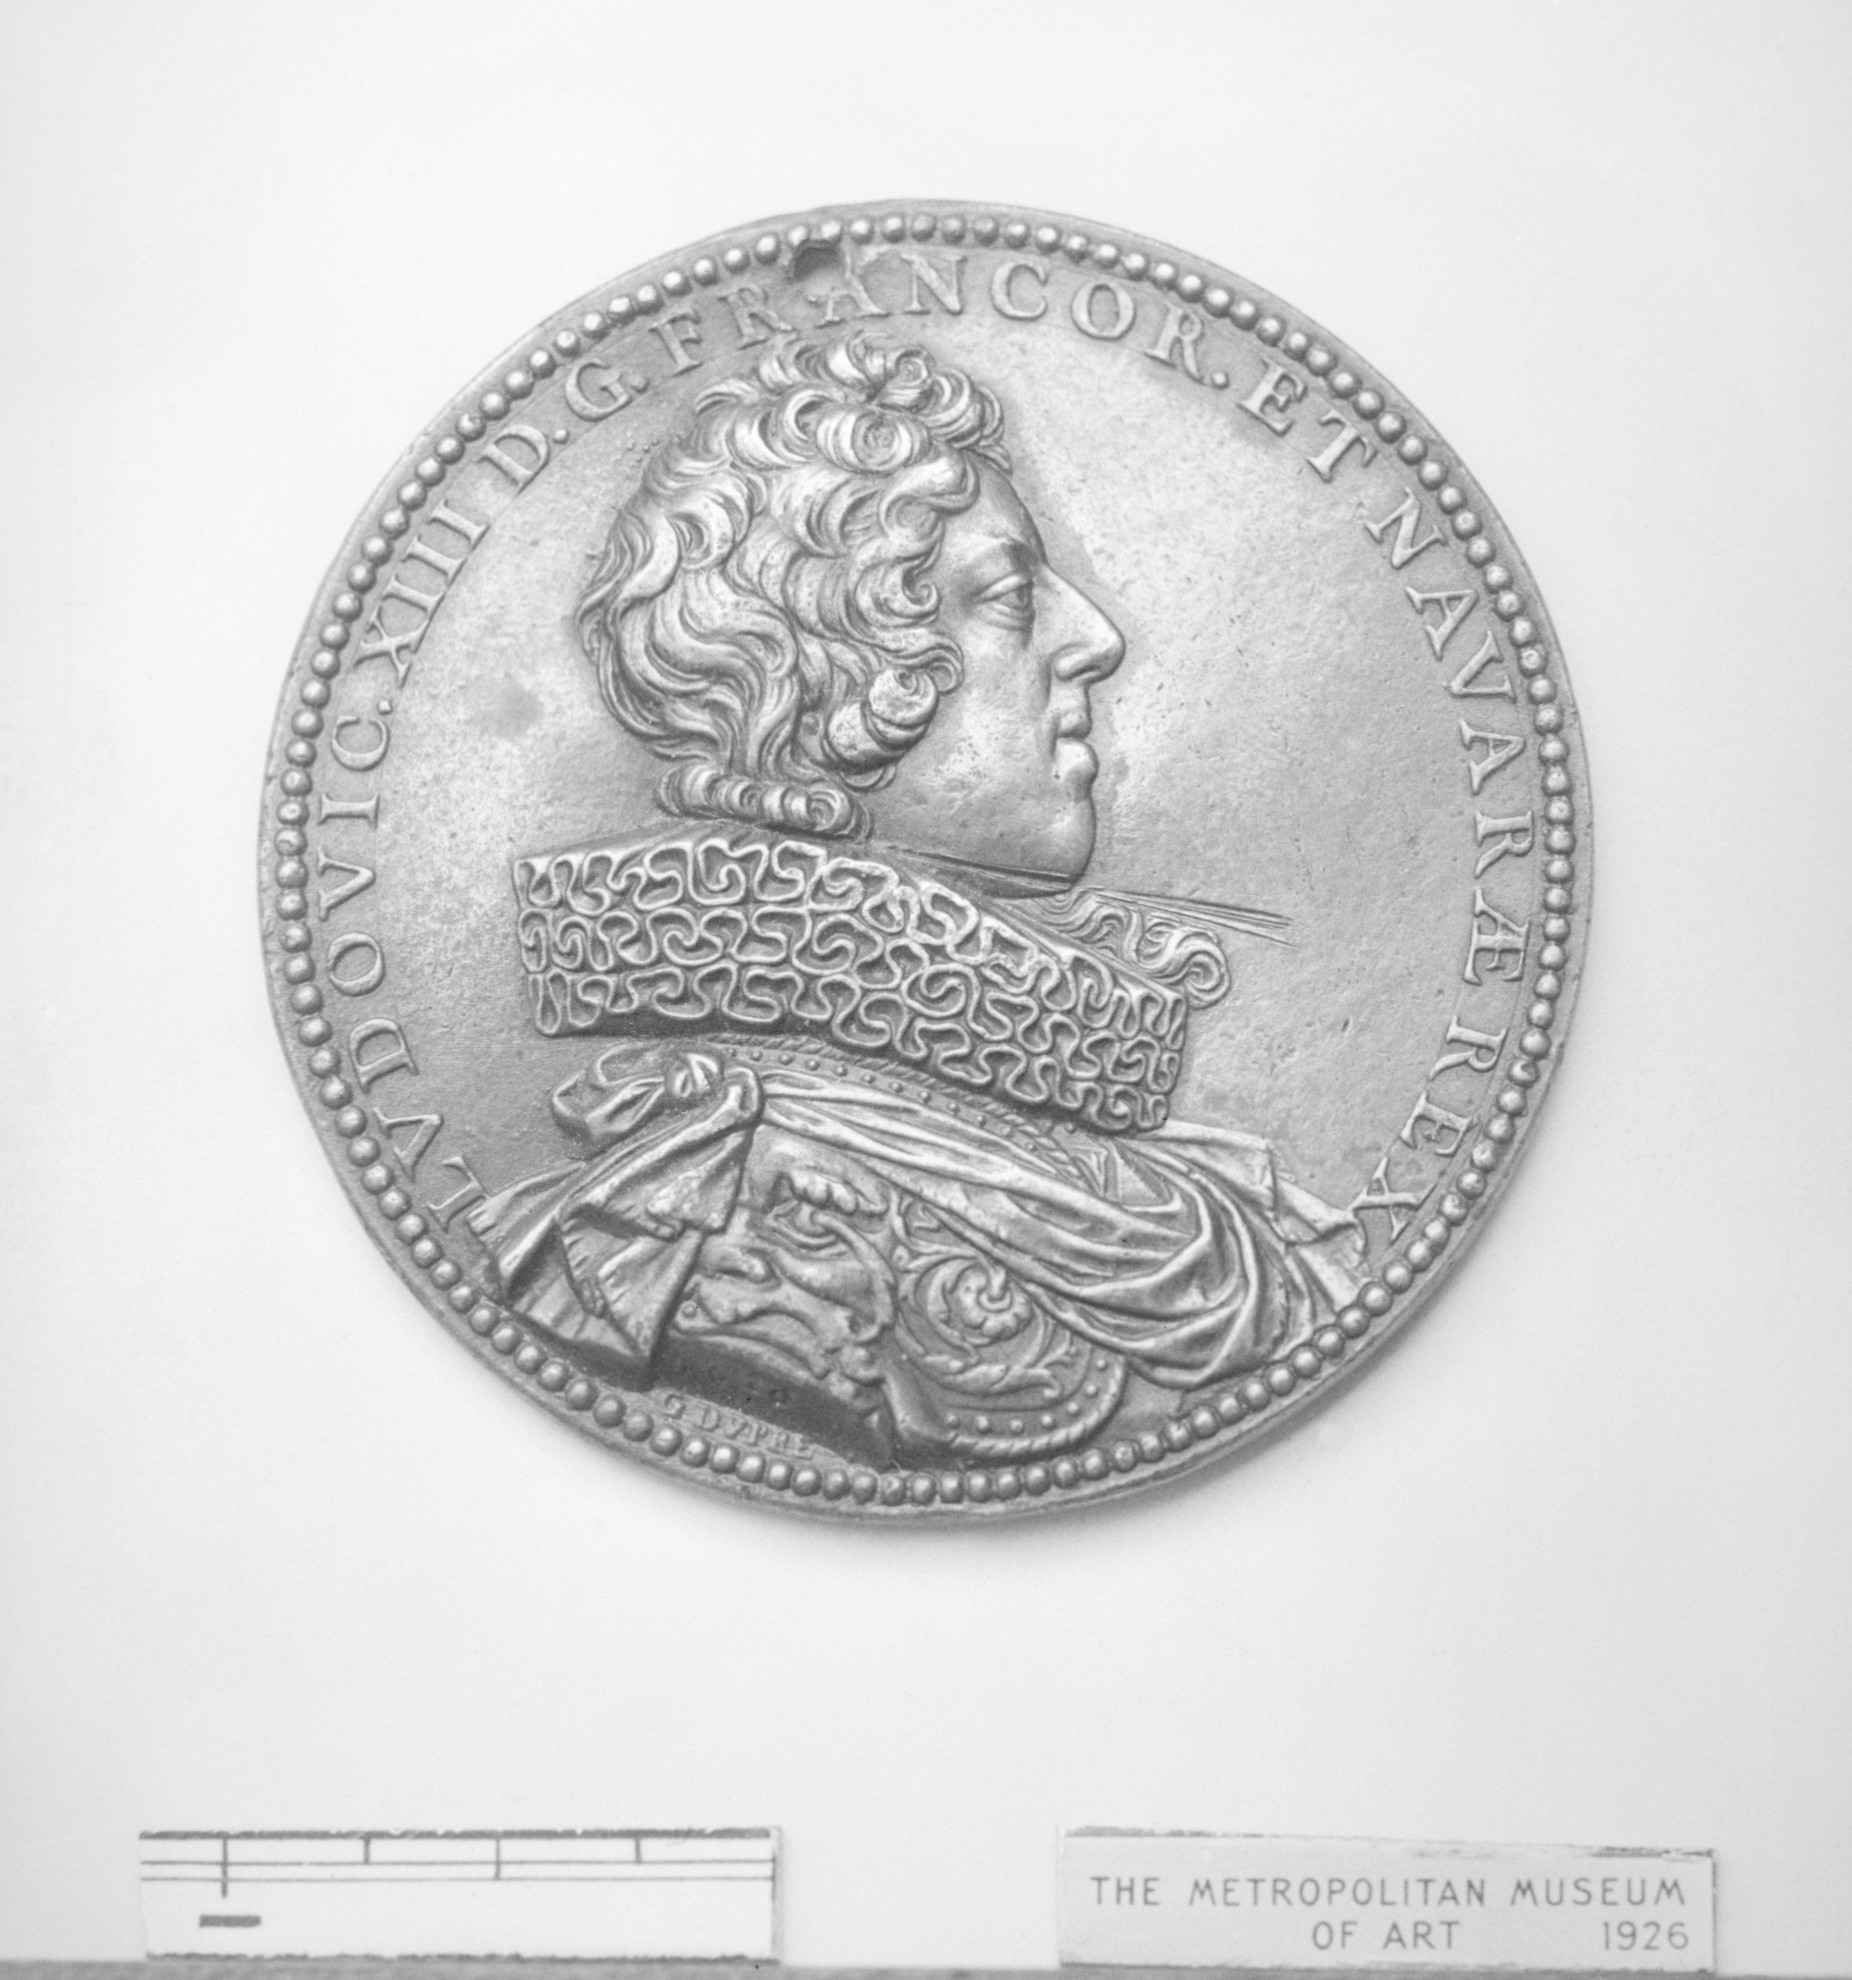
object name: medal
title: Louis XIII, King of France (b. 1601, r. 1610–43)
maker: guillaume dupré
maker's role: artist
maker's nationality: french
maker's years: 1579-1640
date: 1626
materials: bronze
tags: kings,profiles